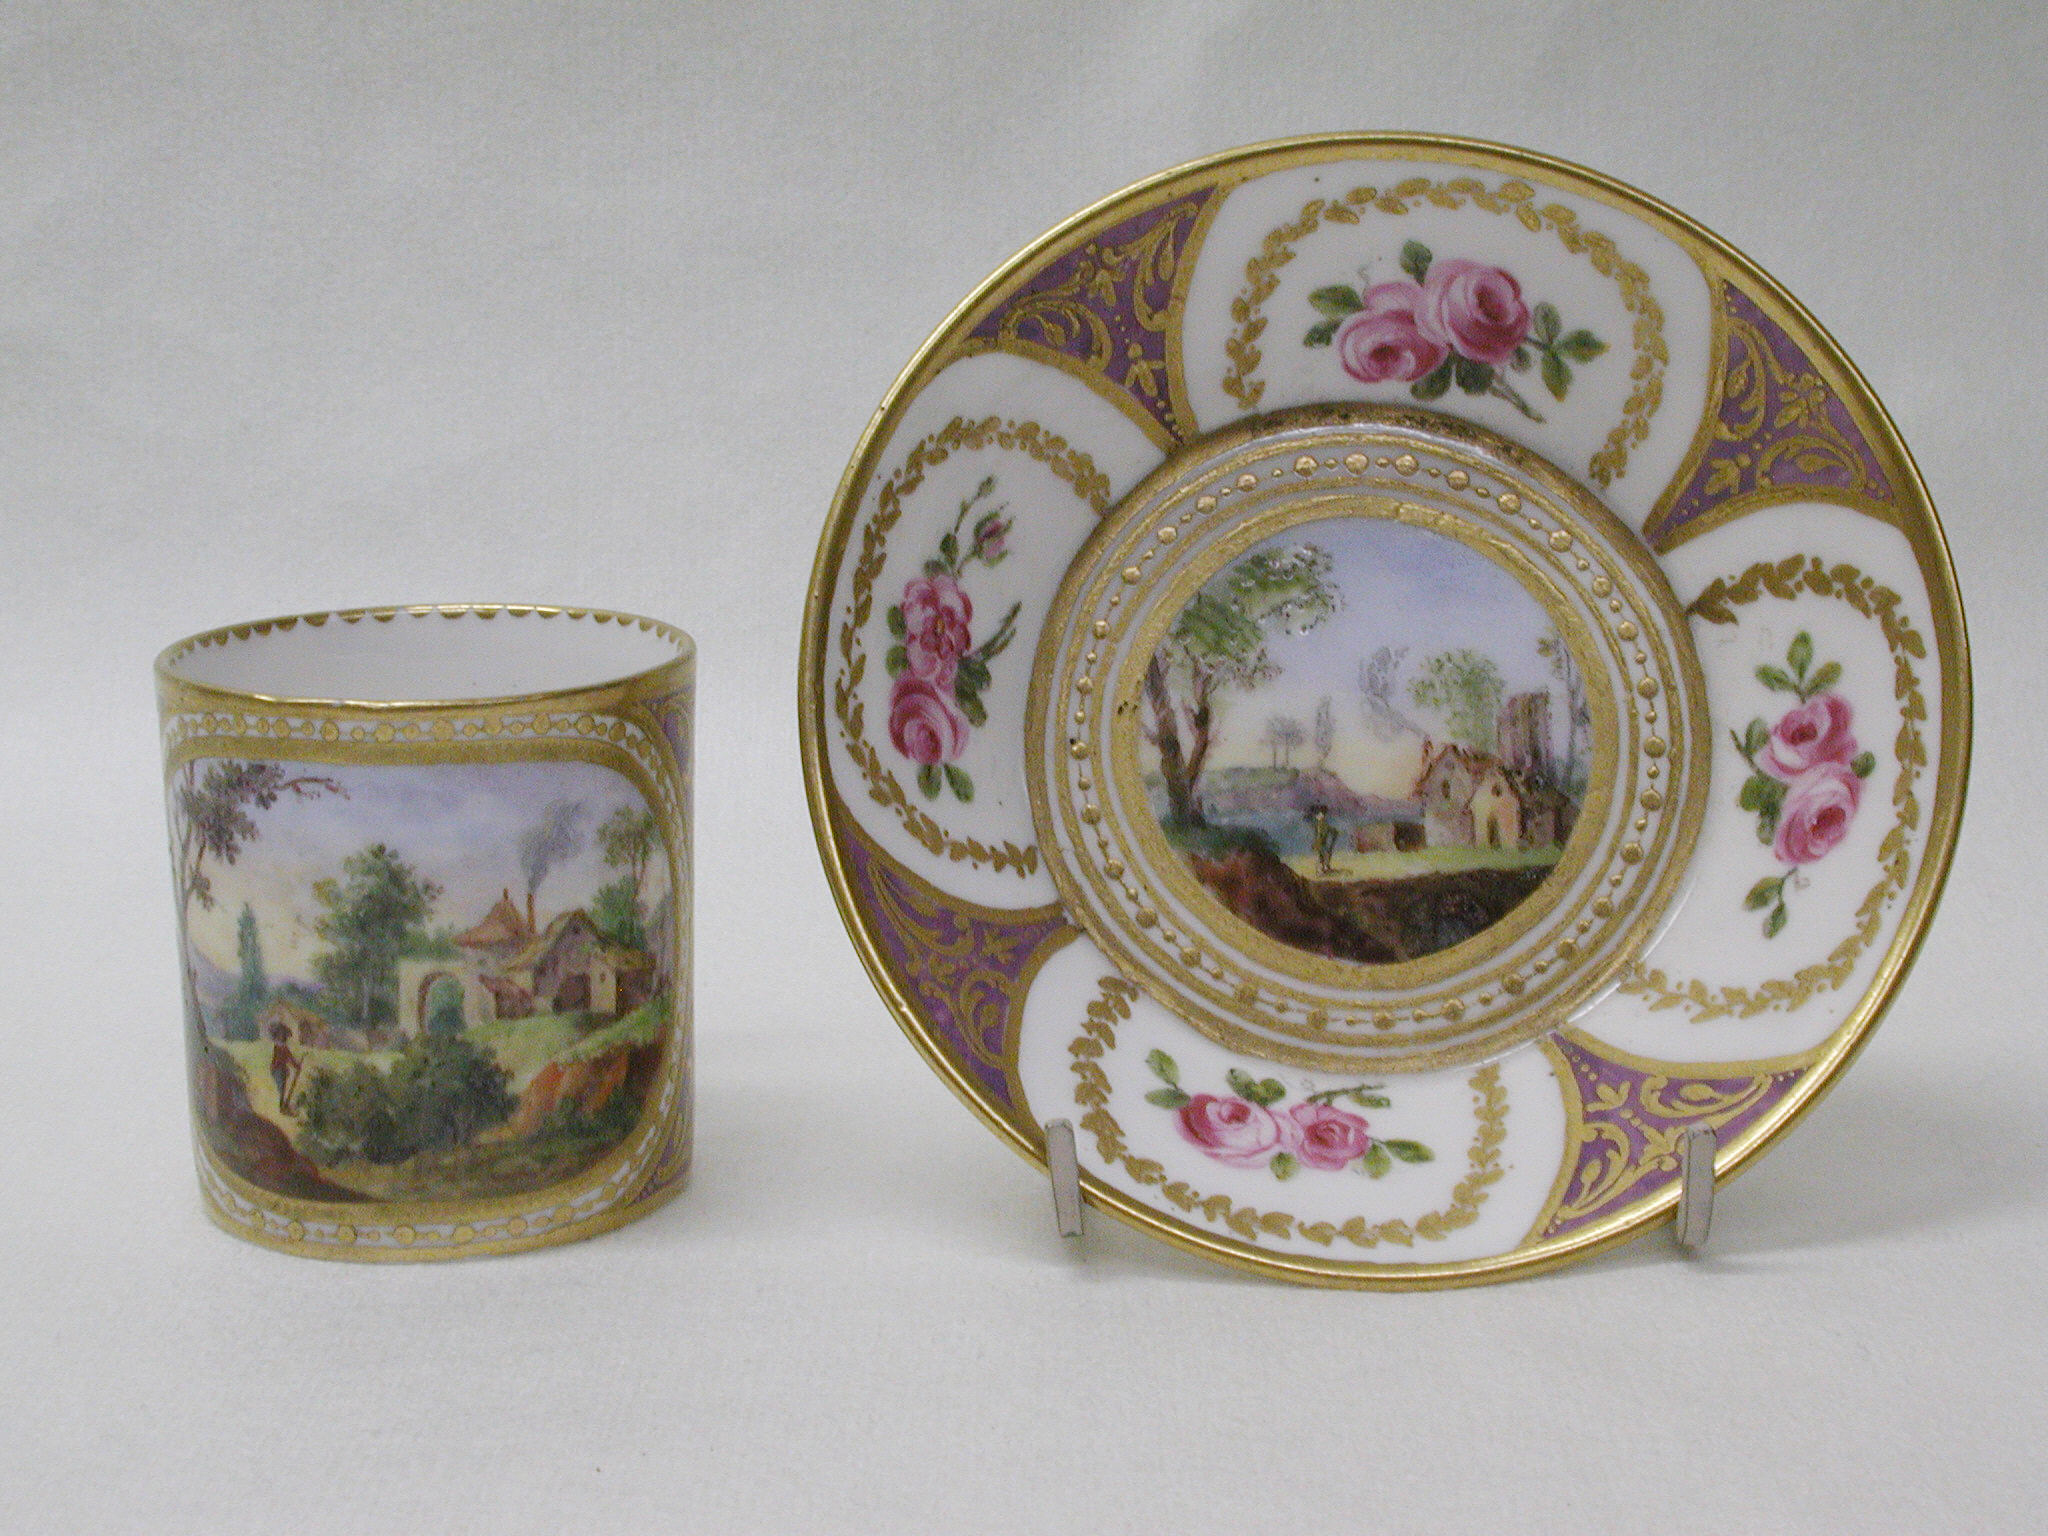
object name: cup and saucer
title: Cup and saucer (gobelet litron et soucoupe)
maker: sèvres manufactory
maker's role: manufactory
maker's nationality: french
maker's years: 1740-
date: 1784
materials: soft paste porcelain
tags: houses,roses,trees